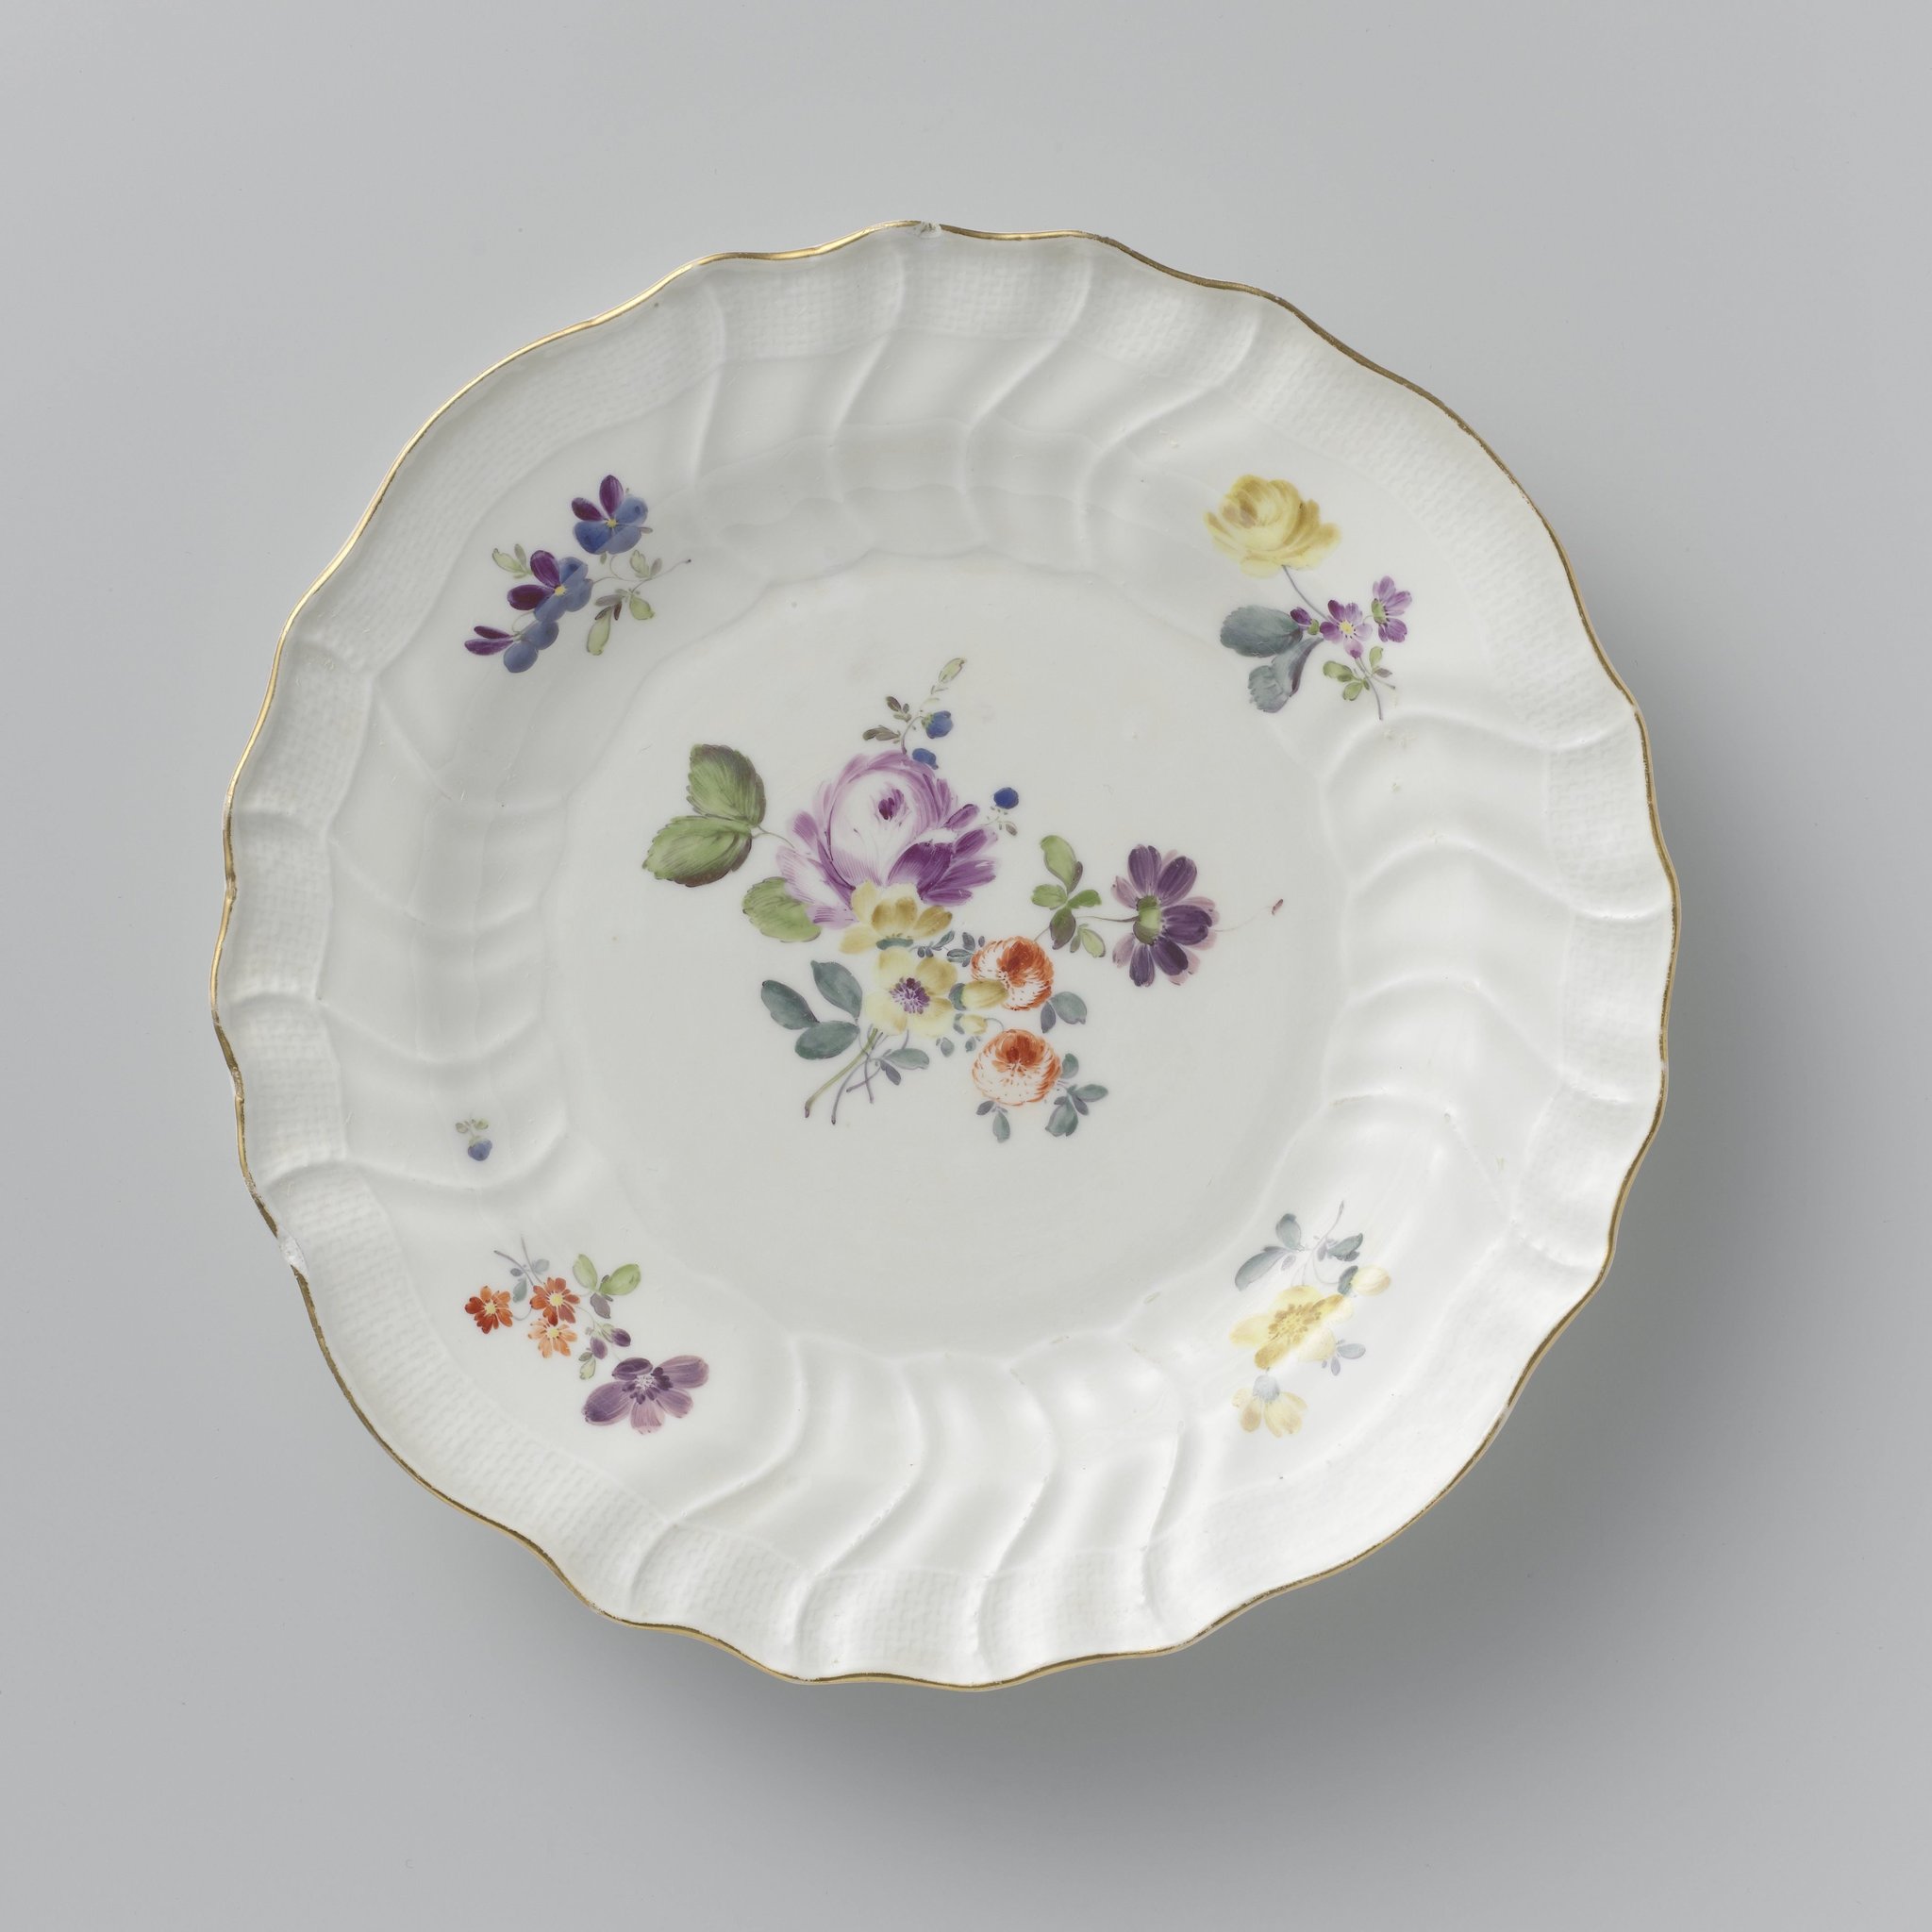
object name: eating drinking utensil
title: Bord, veelkleurig beschilderd met Deutsche Blumen, insekten en vruchten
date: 1750-1760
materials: porcelain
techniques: painted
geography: meissen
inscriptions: factory mark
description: Rond bord van beschilderd porselein. Het bord is beschilderd met Deutsche Blumen, insekten en vruchten. De rand is in reliëf versierd met het Neuozier-patroon. Het bord is gemerkt en hoort bij een servies (BK-17474-1 t/m BK-17474-253).